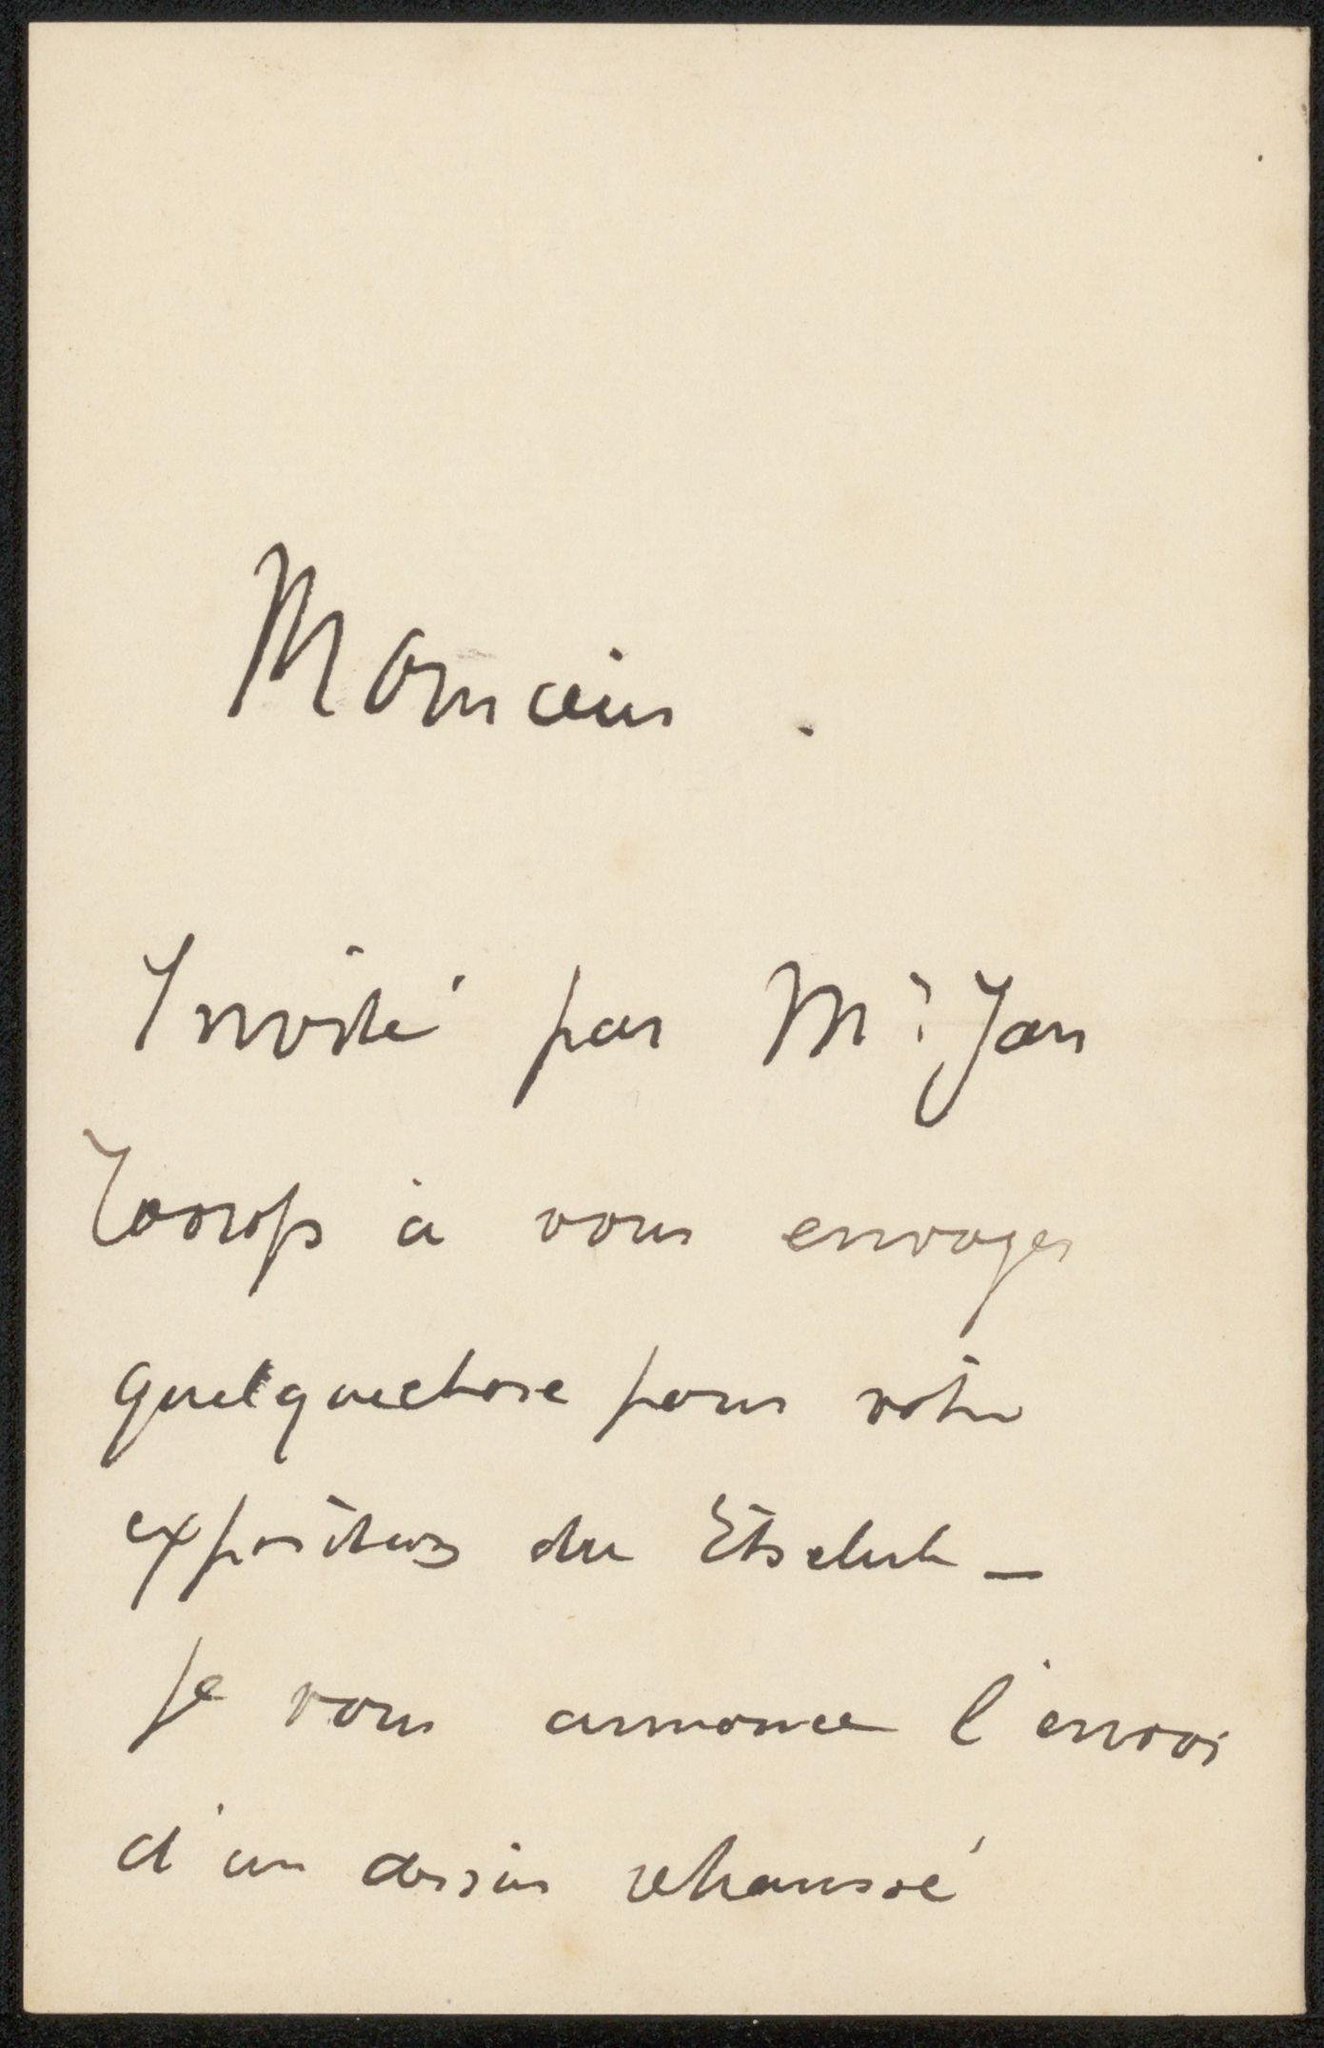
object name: letter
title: Brief aan Philip Zilcken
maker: franz melchers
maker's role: draughtsman, painter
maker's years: 1868-1944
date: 1867-1930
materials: ink, paper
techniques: pen, writing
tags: print maker, jan toorop, the hague, painter, draughtsman, philip zilcken, drawing, exhibition ~ art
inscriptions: collector's mark: ‘RPK’, watermark